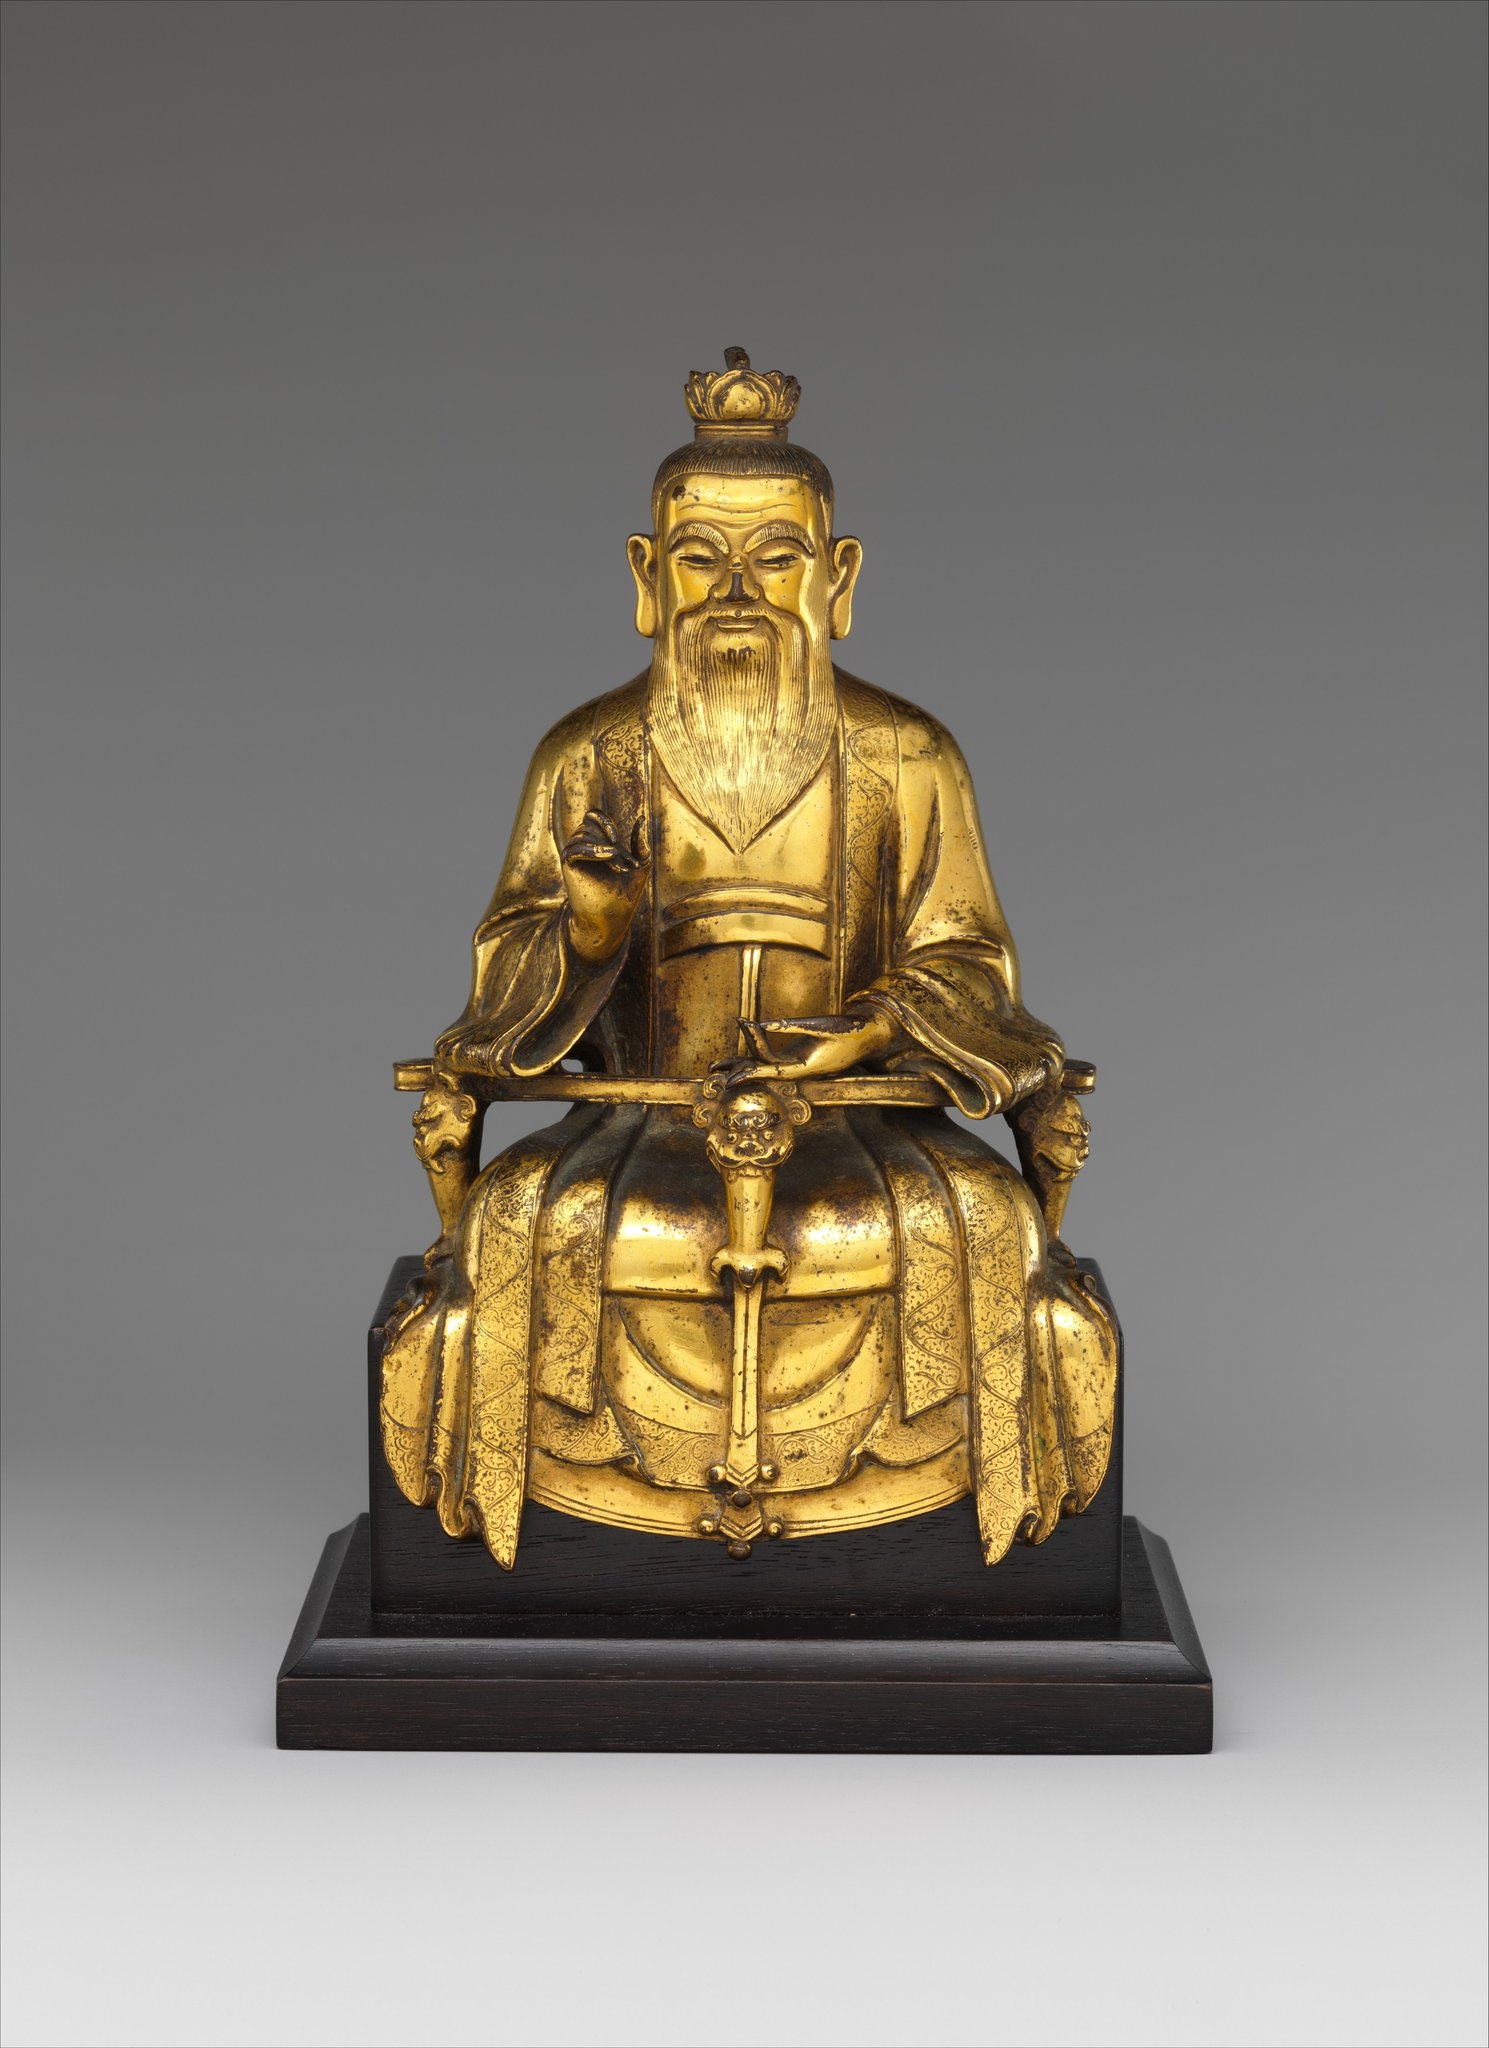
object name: figure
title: Daoist immortal Laozi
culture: chinese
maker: chen yanqing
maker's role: artist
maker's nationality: chinese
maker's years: 1400-1499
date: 1438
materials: copper alloy, gilt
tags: men,daoism